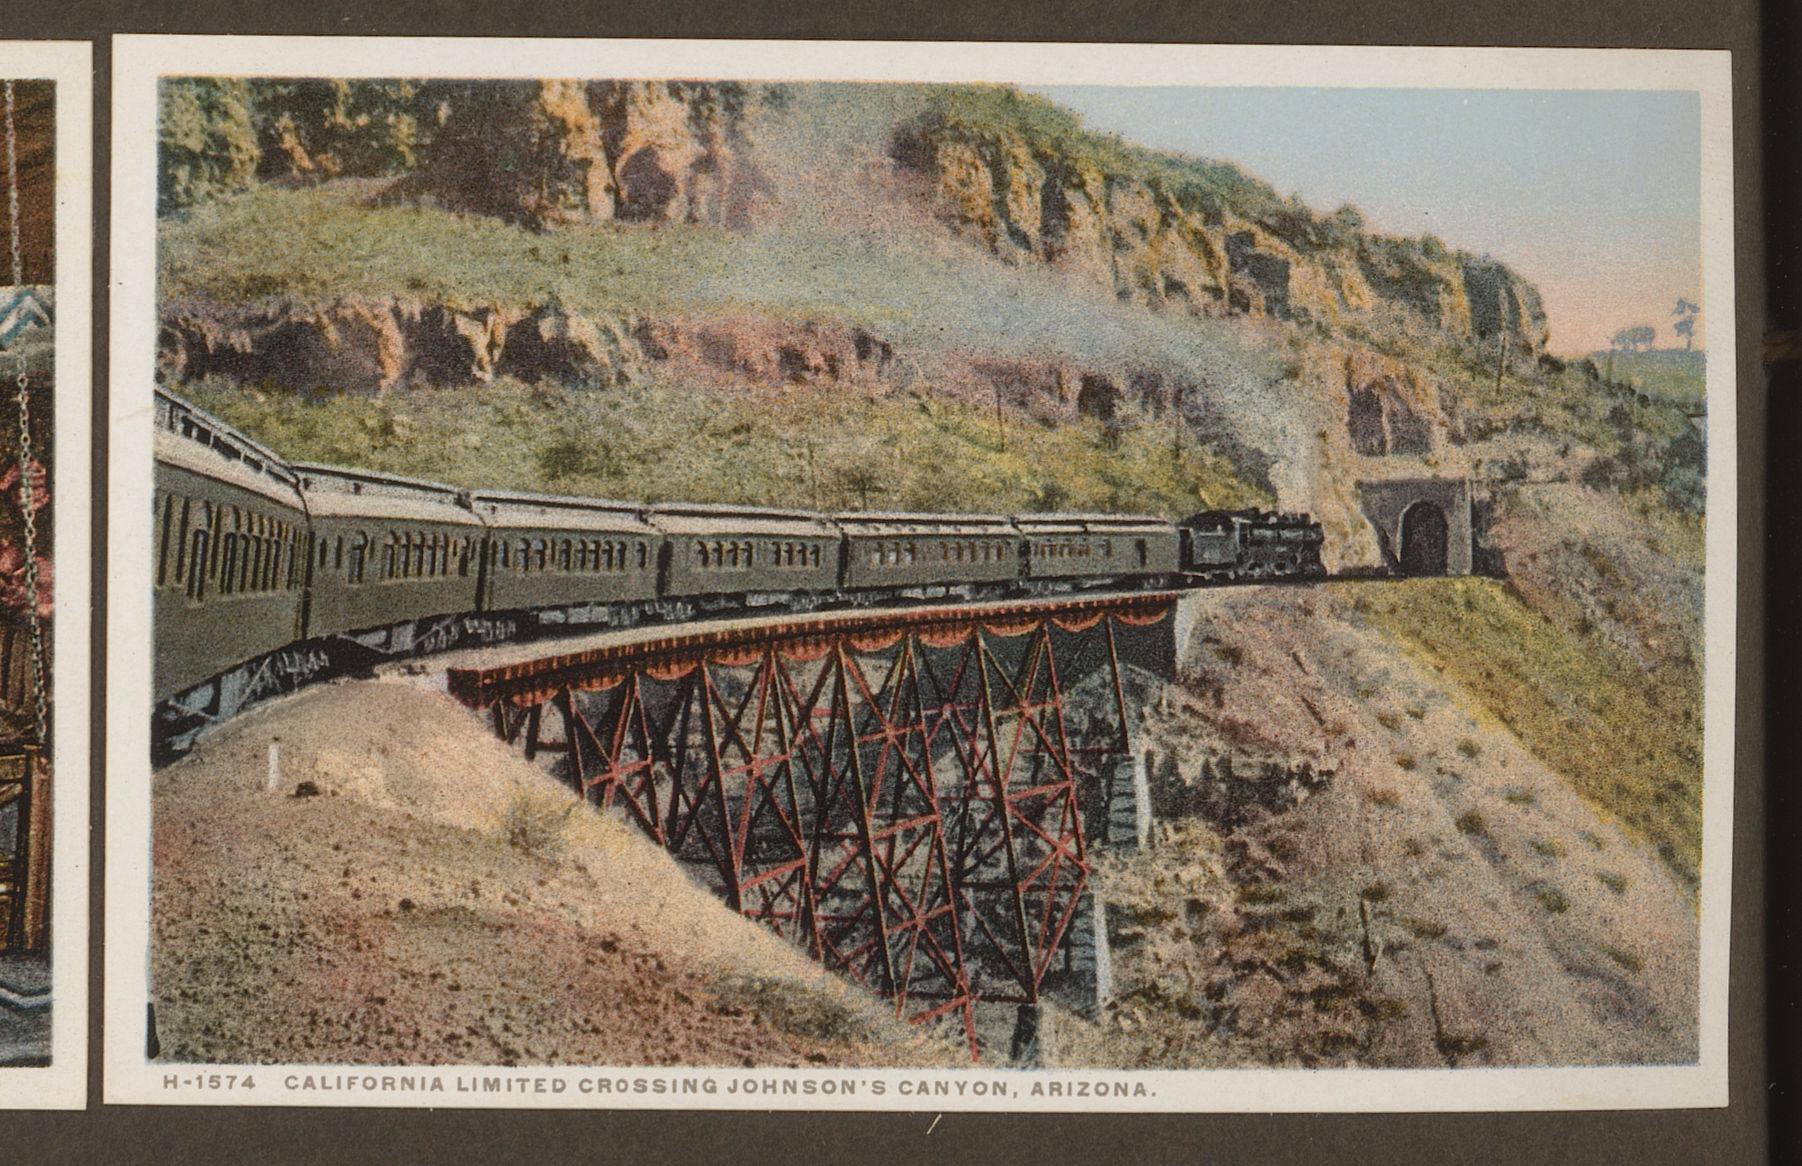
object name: ansichtkaart, prentbriefkaart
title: California Limited crossing Johnson's Canyon, Arizona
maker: Anonymous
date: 1928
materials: paper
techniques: lithograph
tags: ravine, chasm, abyss, canyon, railway, train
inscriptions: number: ‘H-1574’